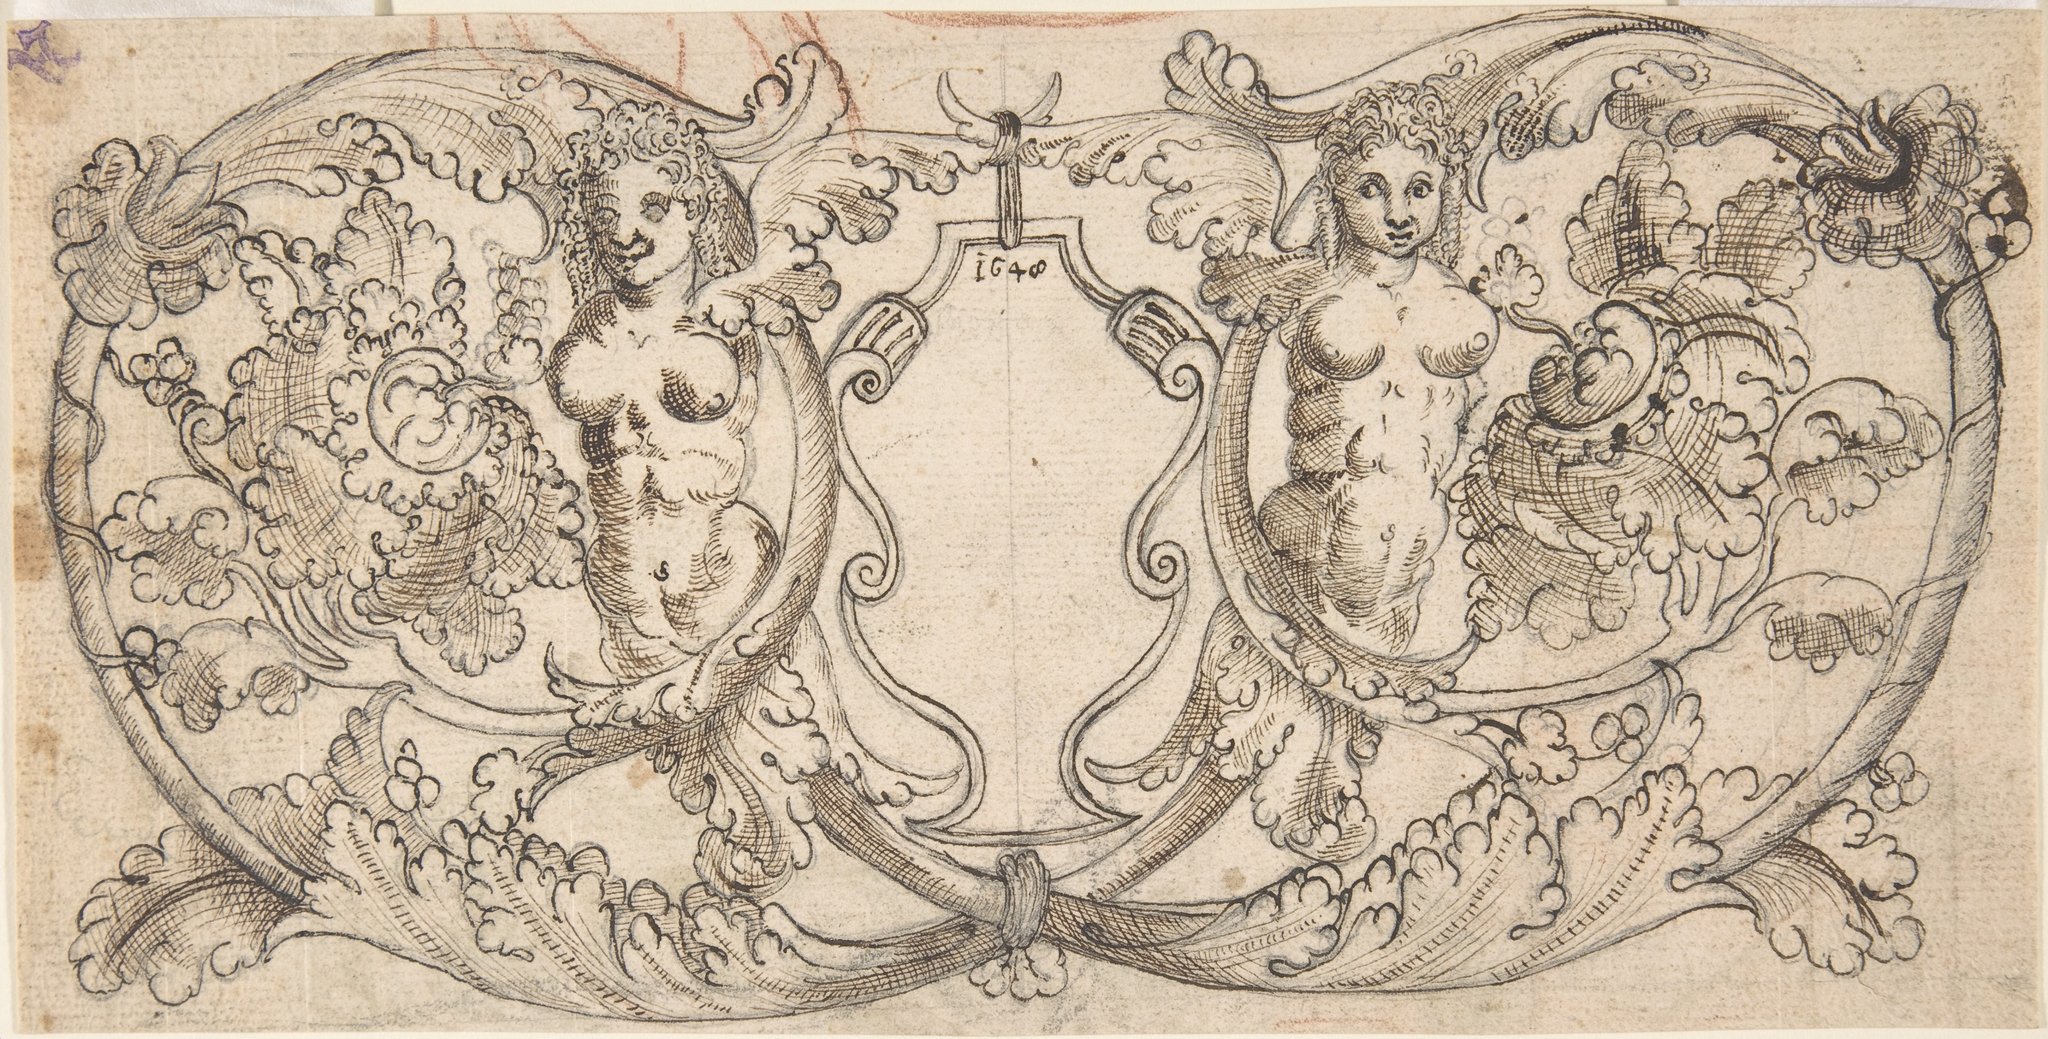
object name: drawing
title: Design for a Cartouche with Acanthus Scrolls from which Female Figures Emerge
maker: anonymous, german, 17th century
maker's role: artist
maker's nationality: german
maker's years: 1600-1700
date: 1648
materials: chalk, graphite, ink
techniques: pen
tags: cartouches,female nudes,acanthus